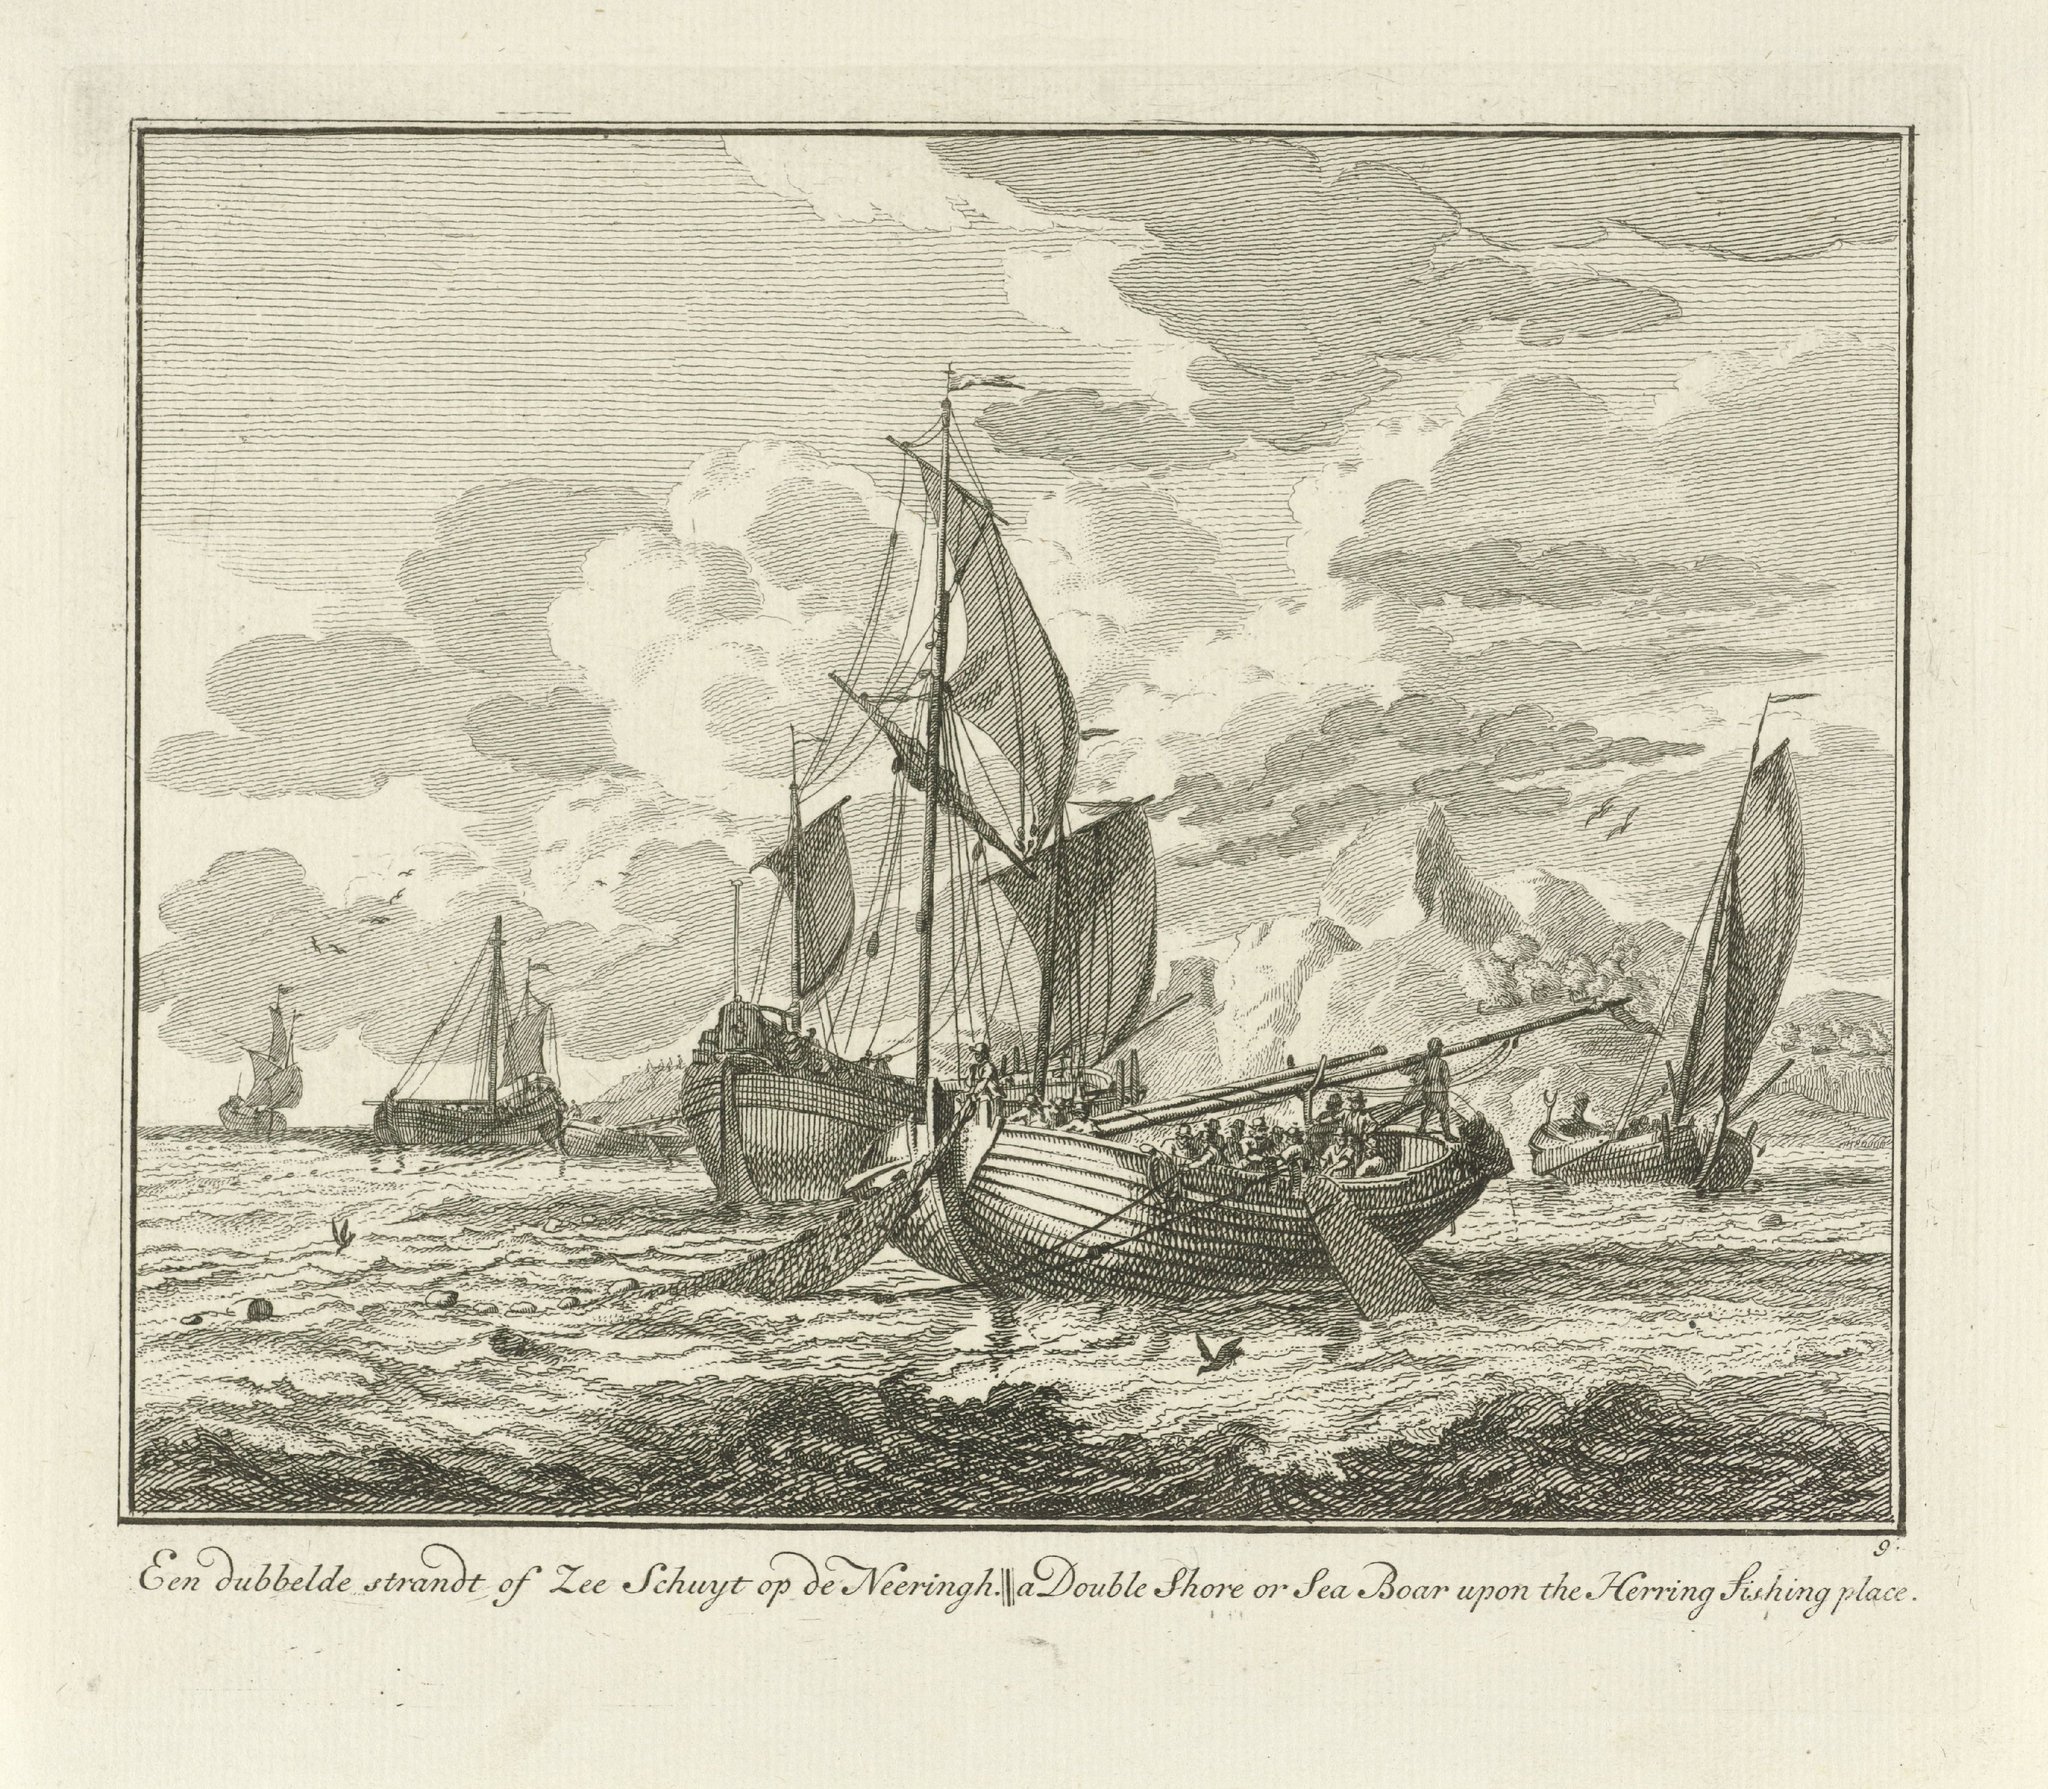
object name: print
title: Dubbele zeeschuit op de nering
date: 1728-1761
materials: paper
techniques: etching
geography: amsterdam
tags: bony fishes: herring, sea and coastal fishery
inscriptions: collector's mark: Lugt 2228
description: Een dubbele zeeschuit met neergehaalde mast vist op zee naar haring, op de achtergrond meer zeilschepen. De prent maakt deel uit van een 32-delige serie prenten met voorstellingen over de haringvangst.